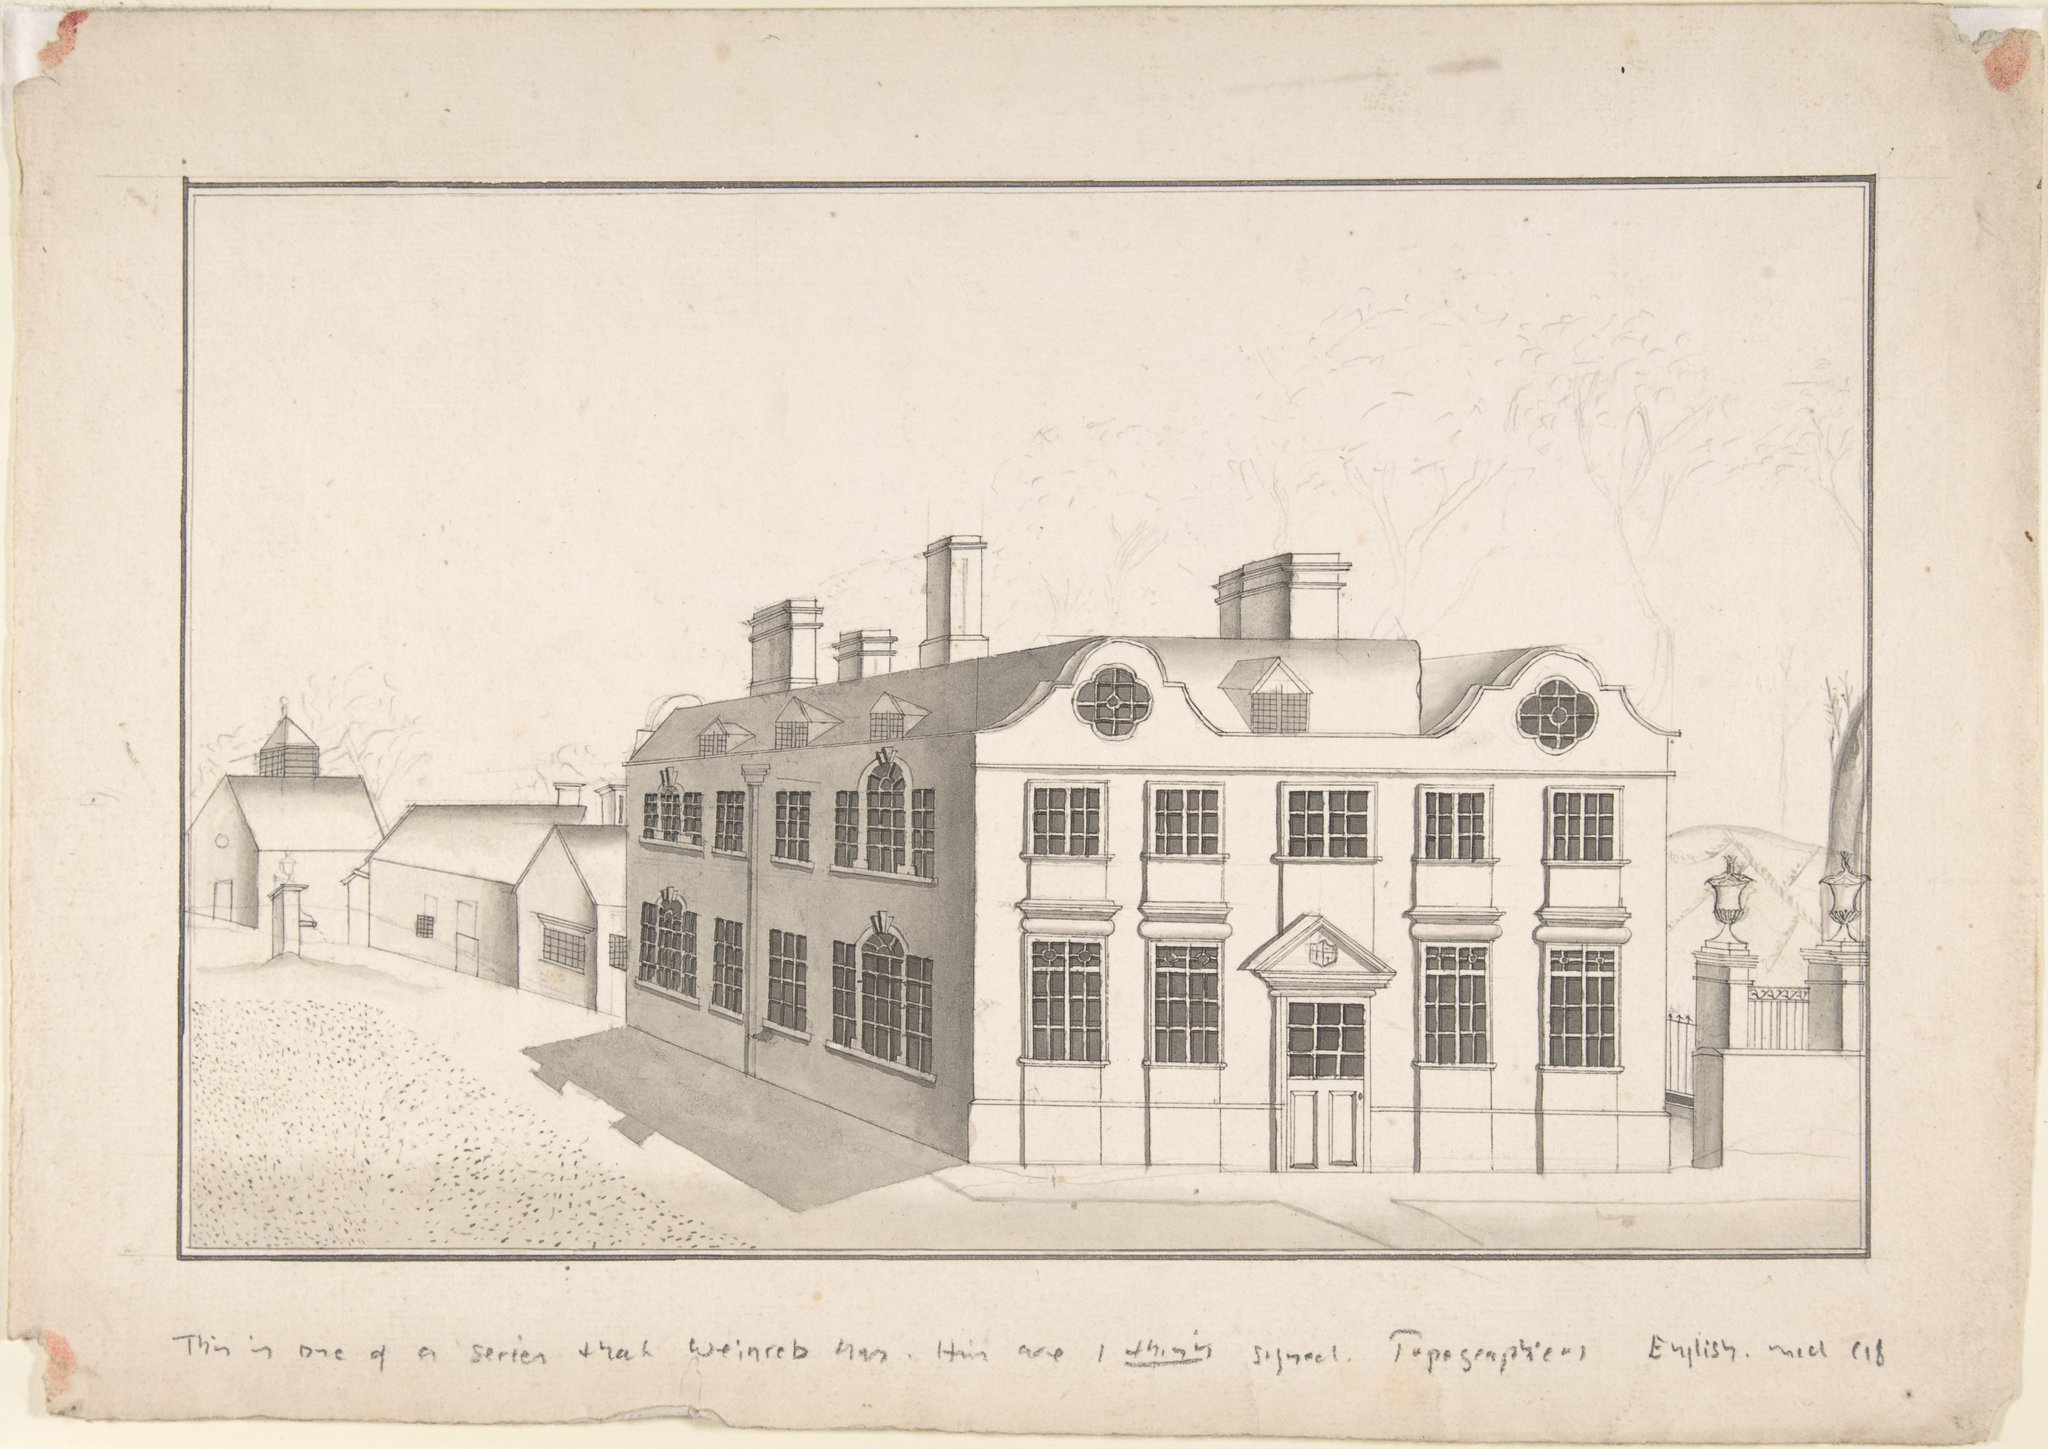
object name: drawing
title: A Jacobean Country House with 18th century alterations (recto); Spired Country Church (verso)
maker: anonymous, british, late 18th–early 19th century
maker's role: artist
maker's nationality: british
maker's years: 1771-1835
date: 1701-1900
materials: graphite, ink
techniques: brush, pen, wash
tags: houses